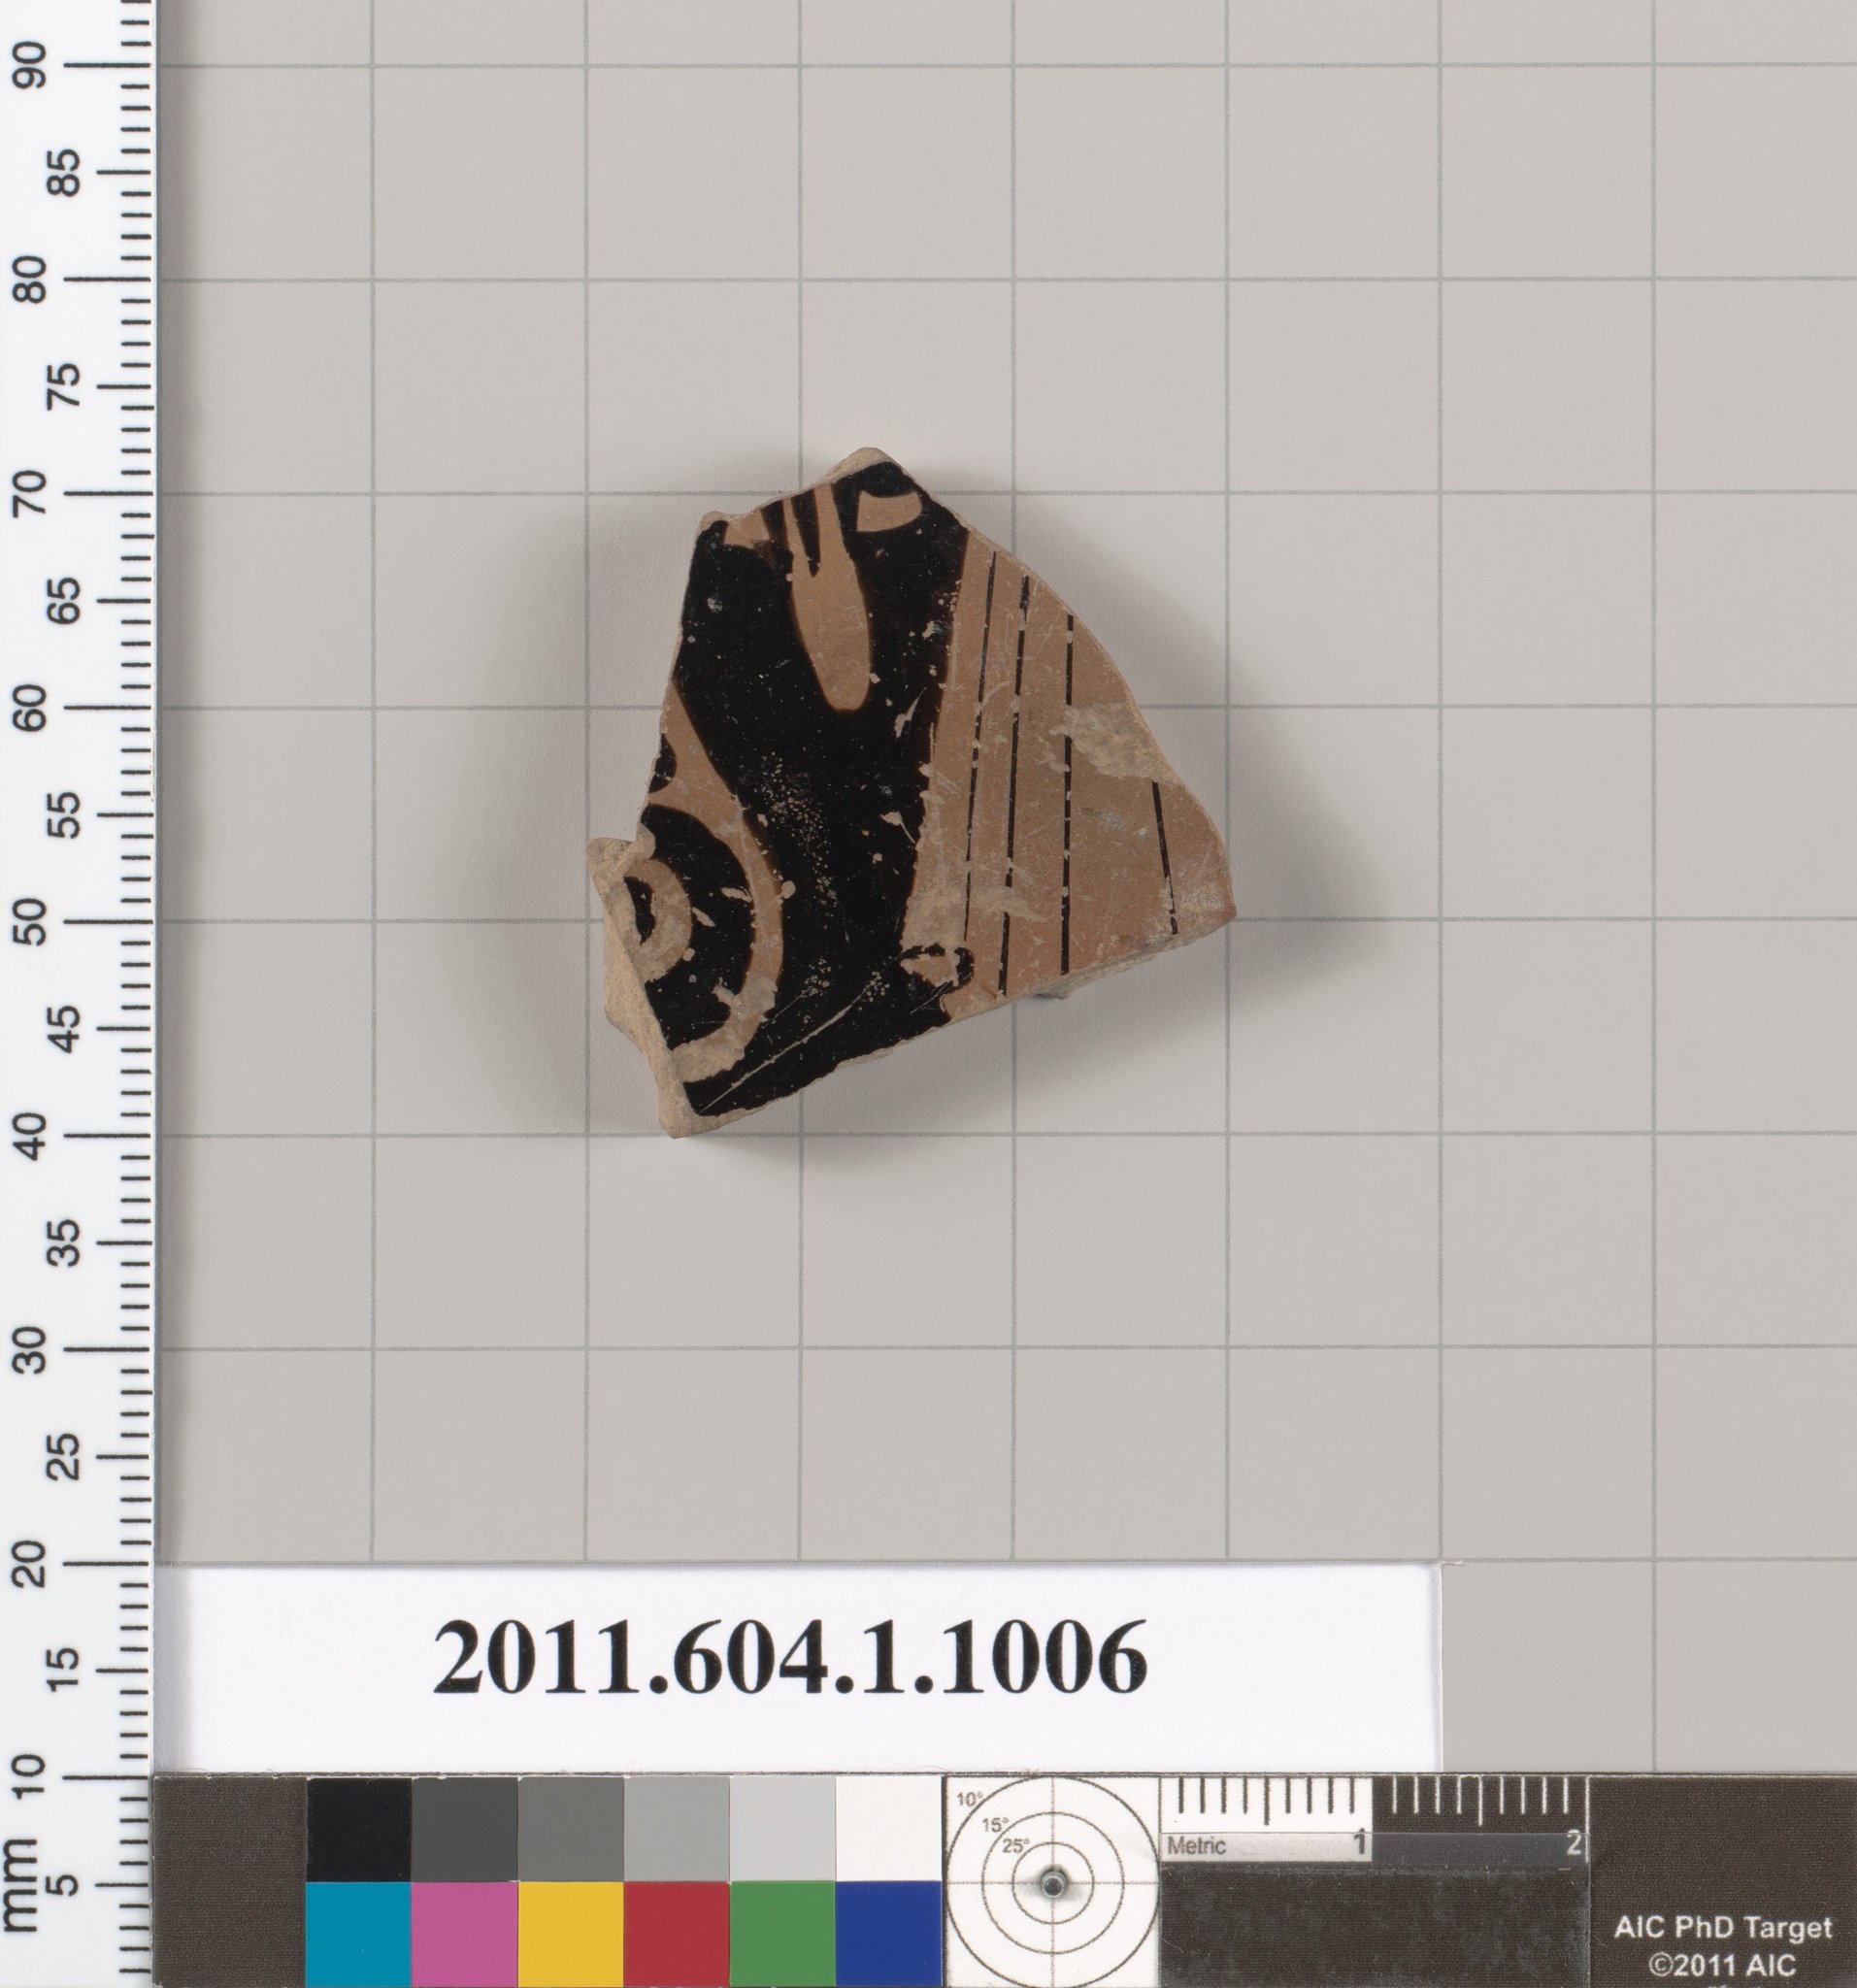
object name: kylix fragment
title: Terracotta fragment of a kylix (drinking cup)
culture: greek, attic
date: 475-451 BCE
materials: terracotta